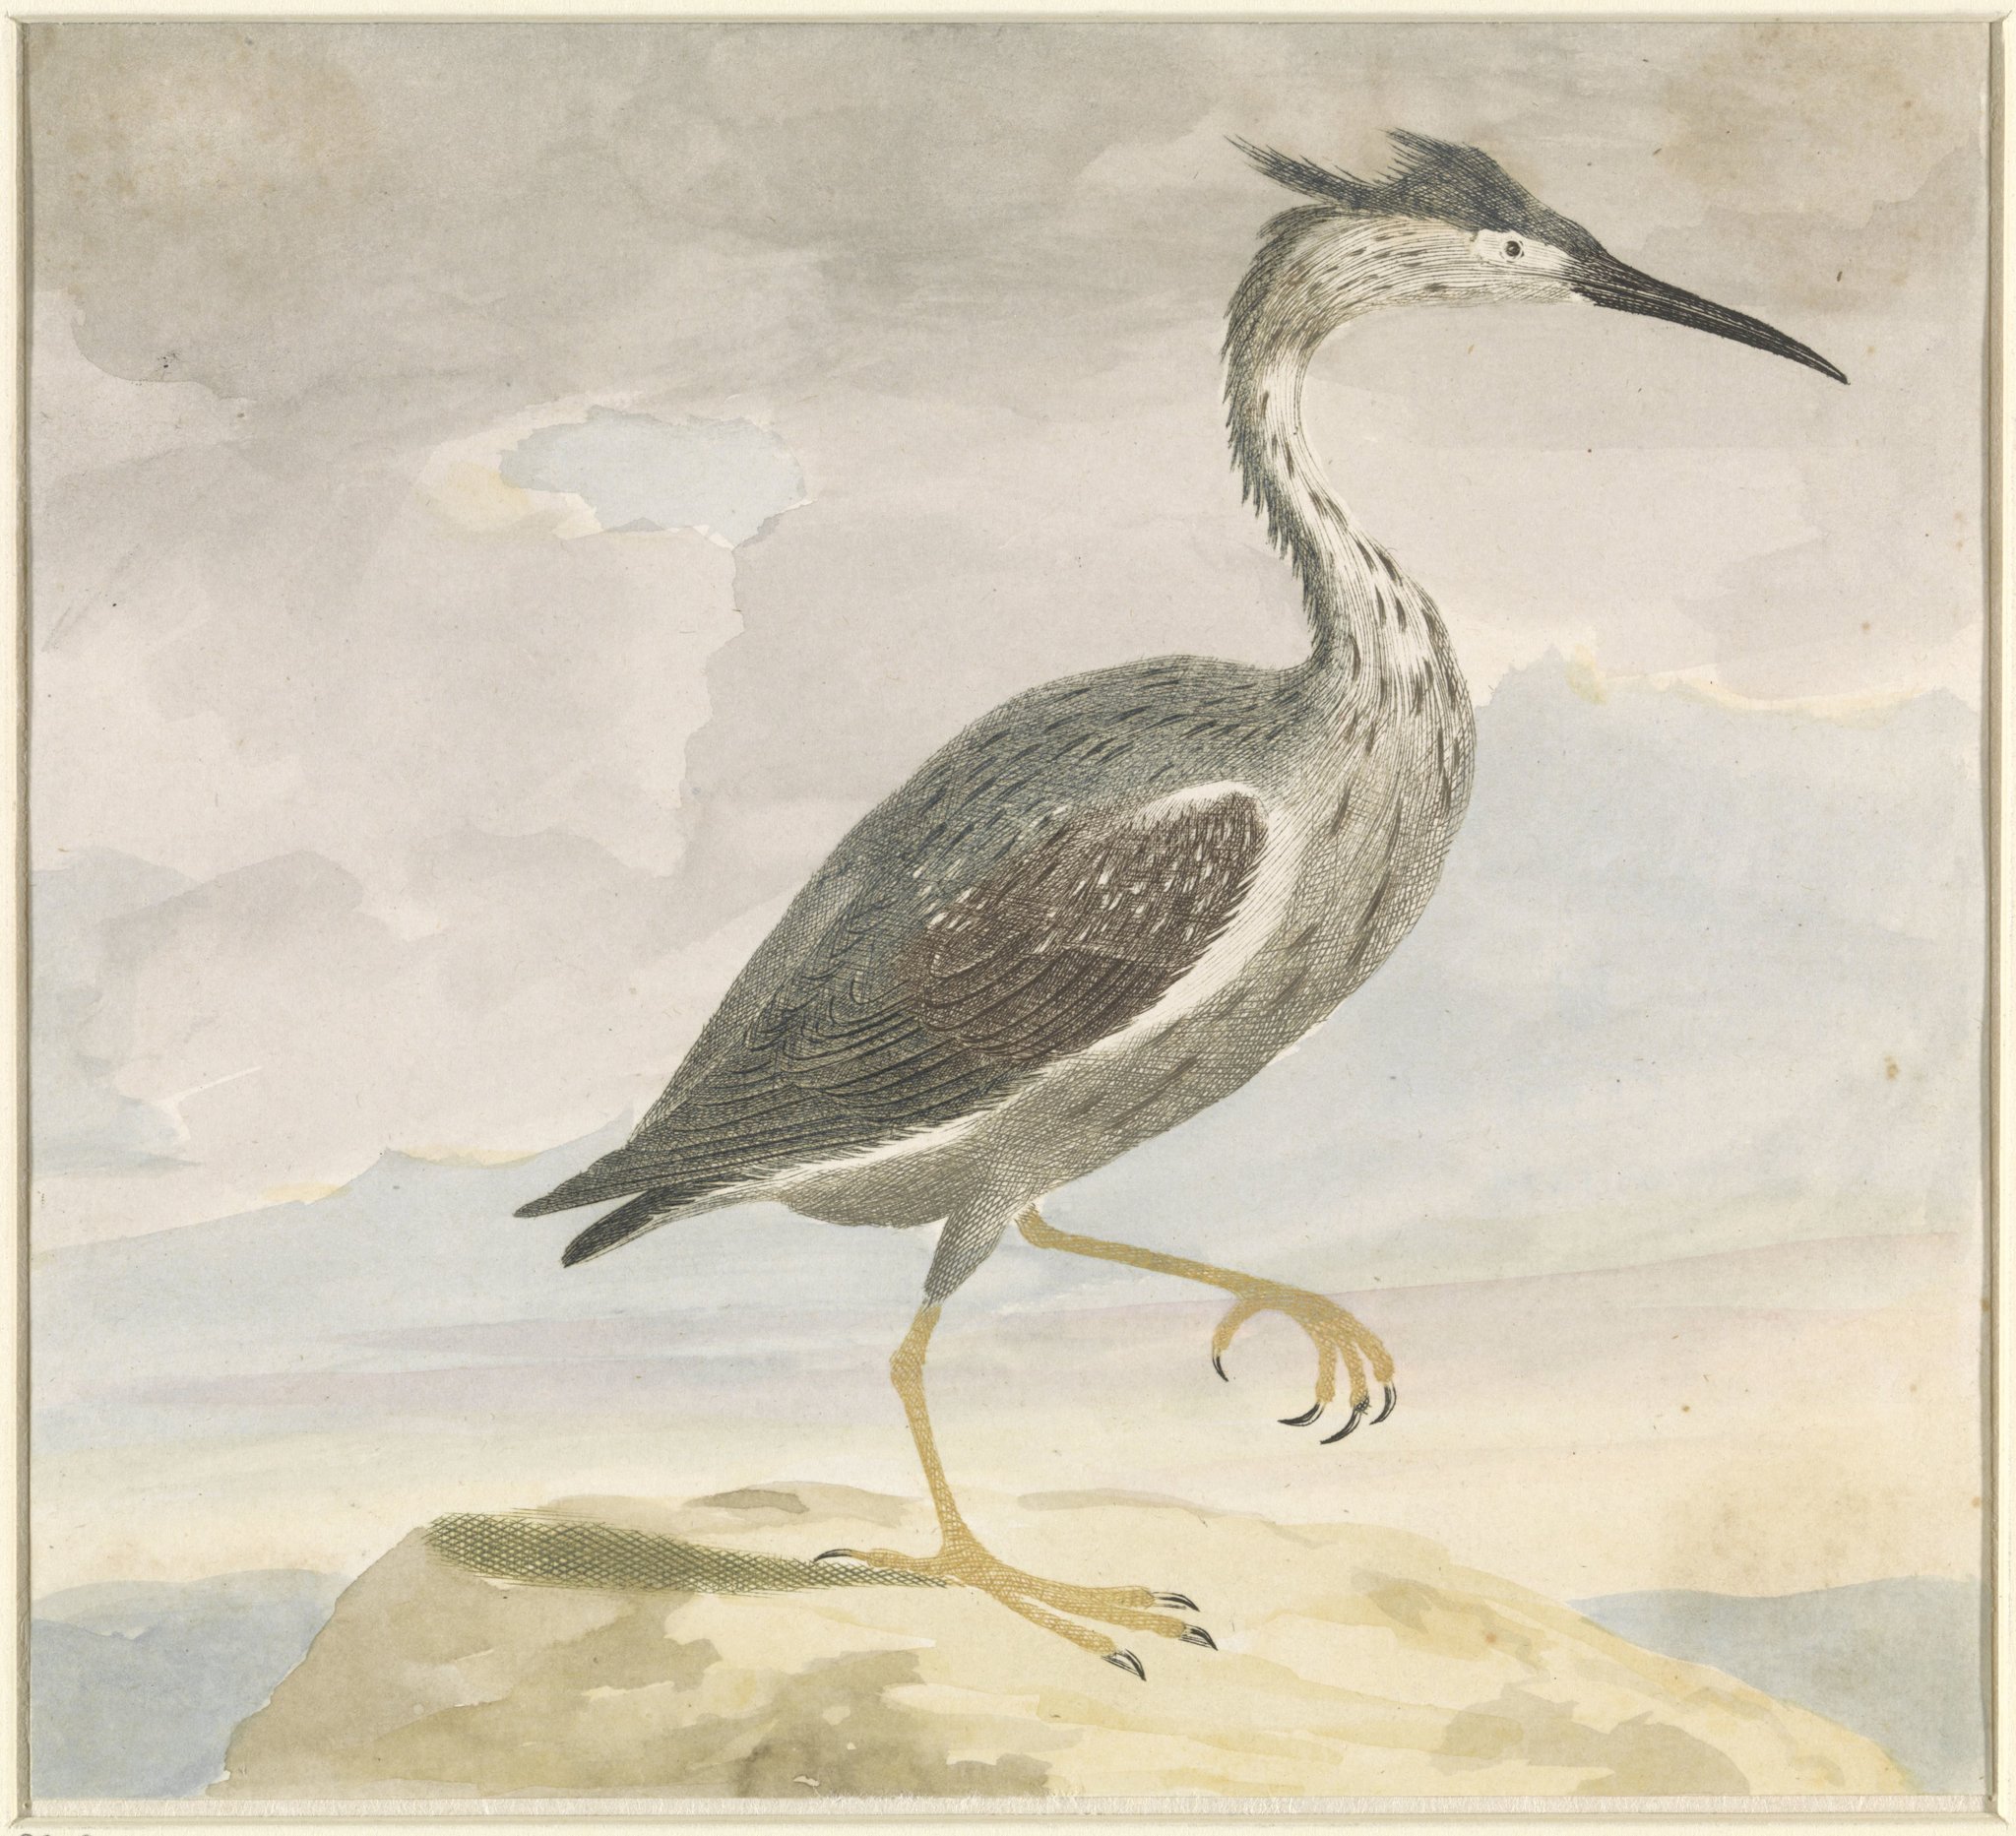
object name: print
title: Reiger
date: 1688-1698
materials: paper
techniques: printing, engraving, hand coloring, lithography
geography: netherlands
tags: shore-birds and wading-birds: heron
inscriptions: collector's mark: Lugt 2760, collector's mark: Lugt 2228